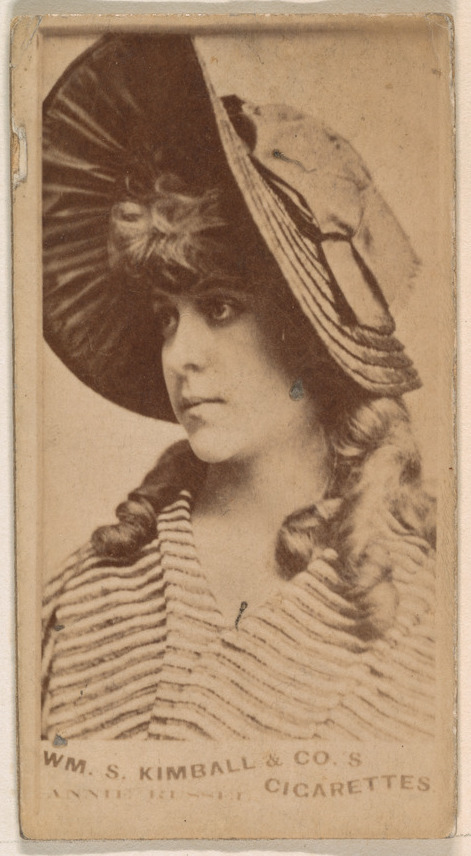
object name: photograph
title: Annie Russell, from the Actresses series (N203) issued by Wm. S. Kimball & Co.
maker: william s. kimball & company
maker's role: publisher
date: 1889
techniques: color lithograph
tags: portraits,women,actresses